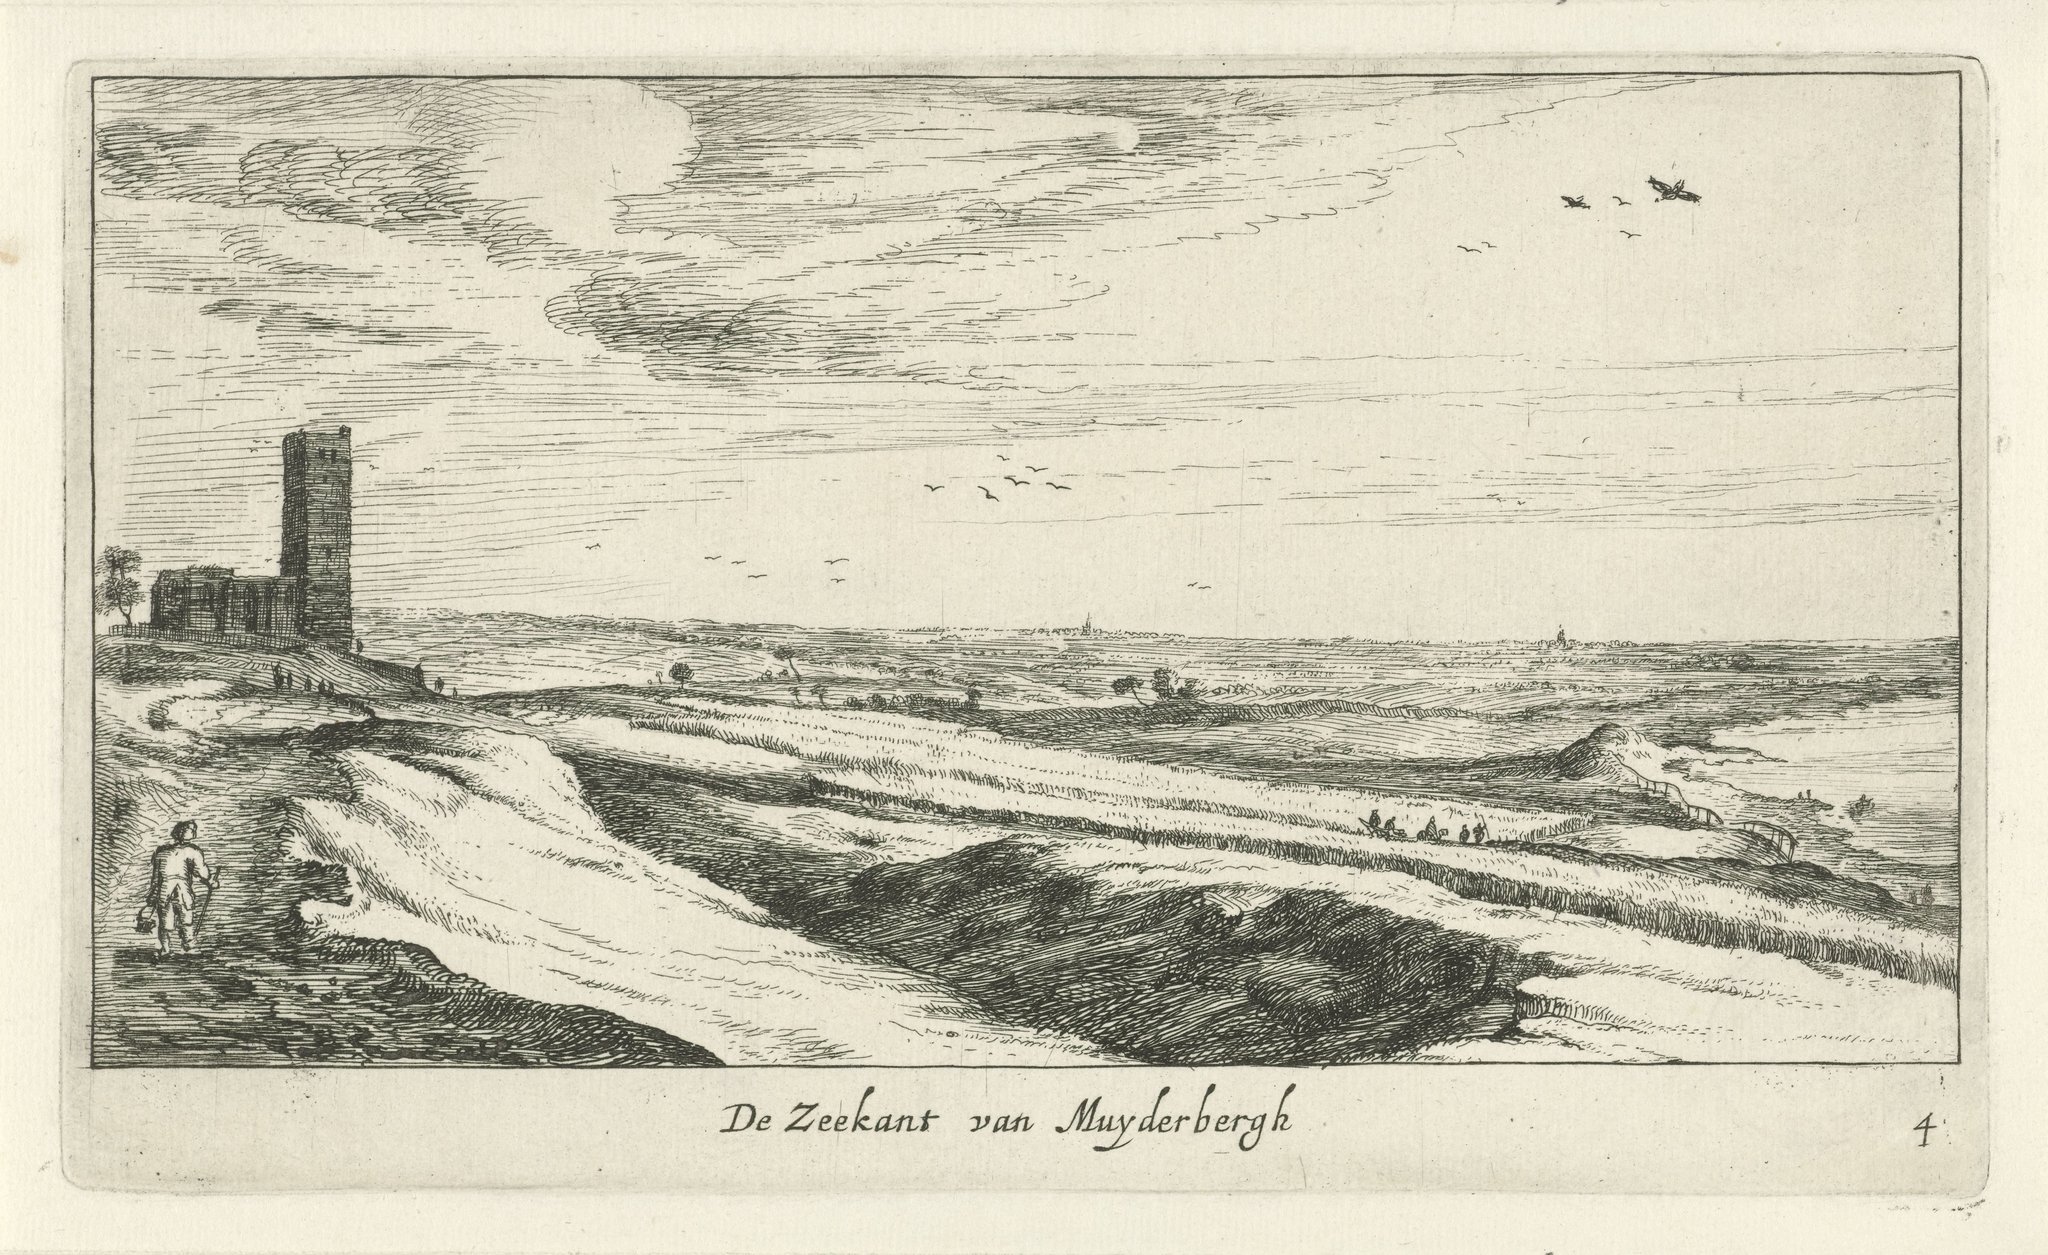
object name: print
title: Plaisante Lantschappen ofte vermakelijcke Gesichten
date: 1637-1652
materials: paper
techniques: engraving, etching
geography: amsterdam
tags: church (exterior), zuiderzee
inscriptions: collector's mark: Lugt 240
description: Gezicht vanaf Muiderberg op de Zuiderzee, met links de oude kerk (tegenwoordig Kerk aan Zee genoemd) met zijn stompe toren. De prent is deel van een serie landschappen met dorpen rondom Amsterdam. Rechtsonder genummerd: 4.